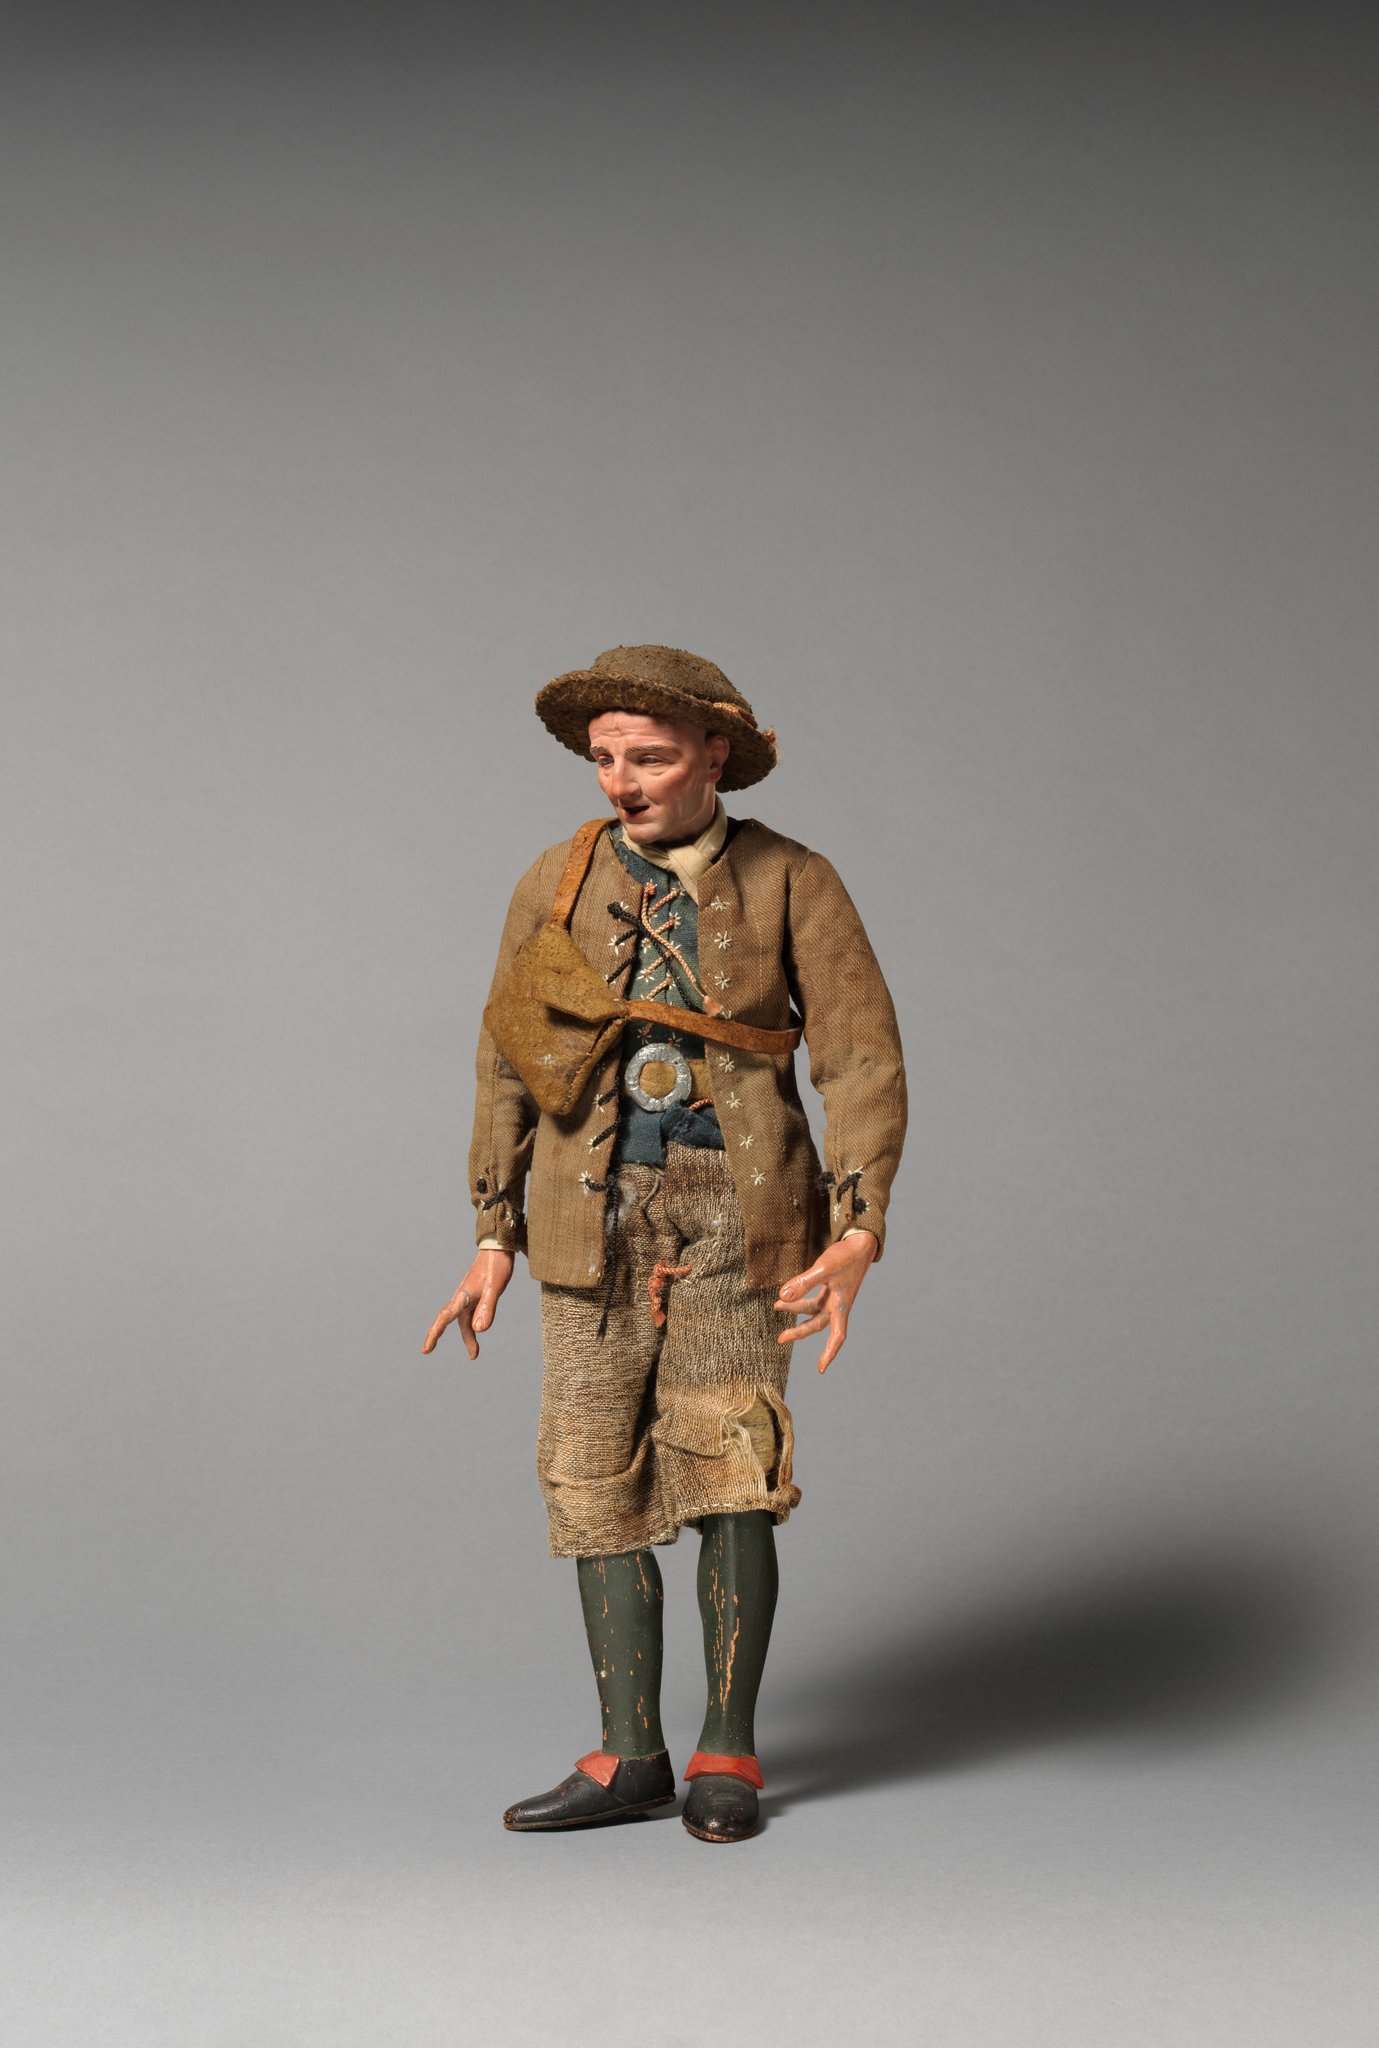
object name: crèche figure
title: Man in brimmed hat, brown lace-up jacket, green vest, belt buckle, shoulder bag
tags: men